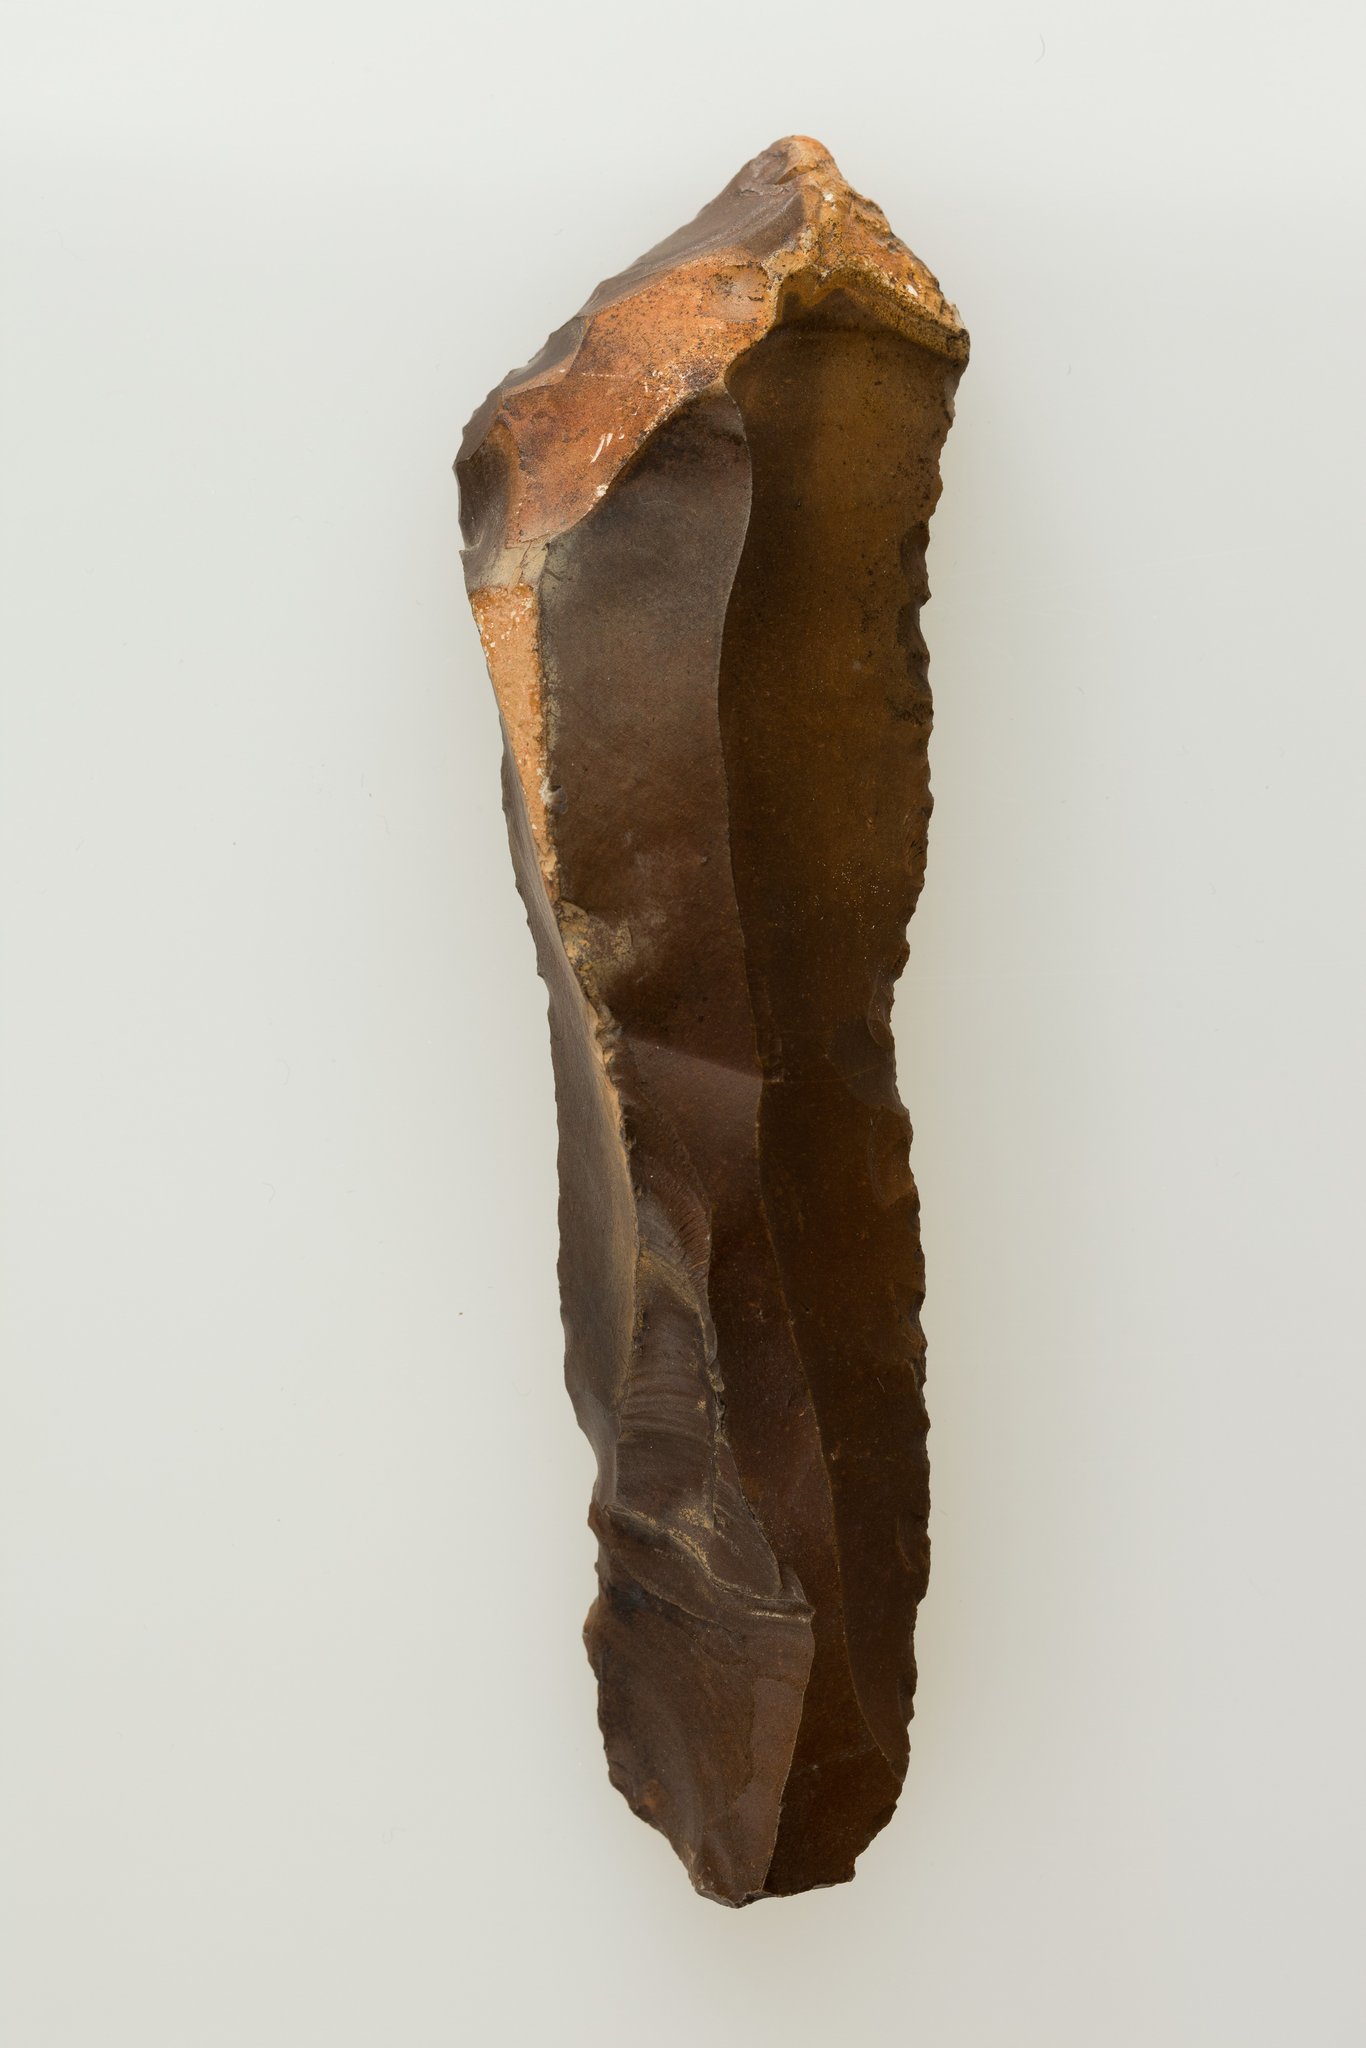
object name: tool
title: Retouched Blade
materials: stone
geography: egypt